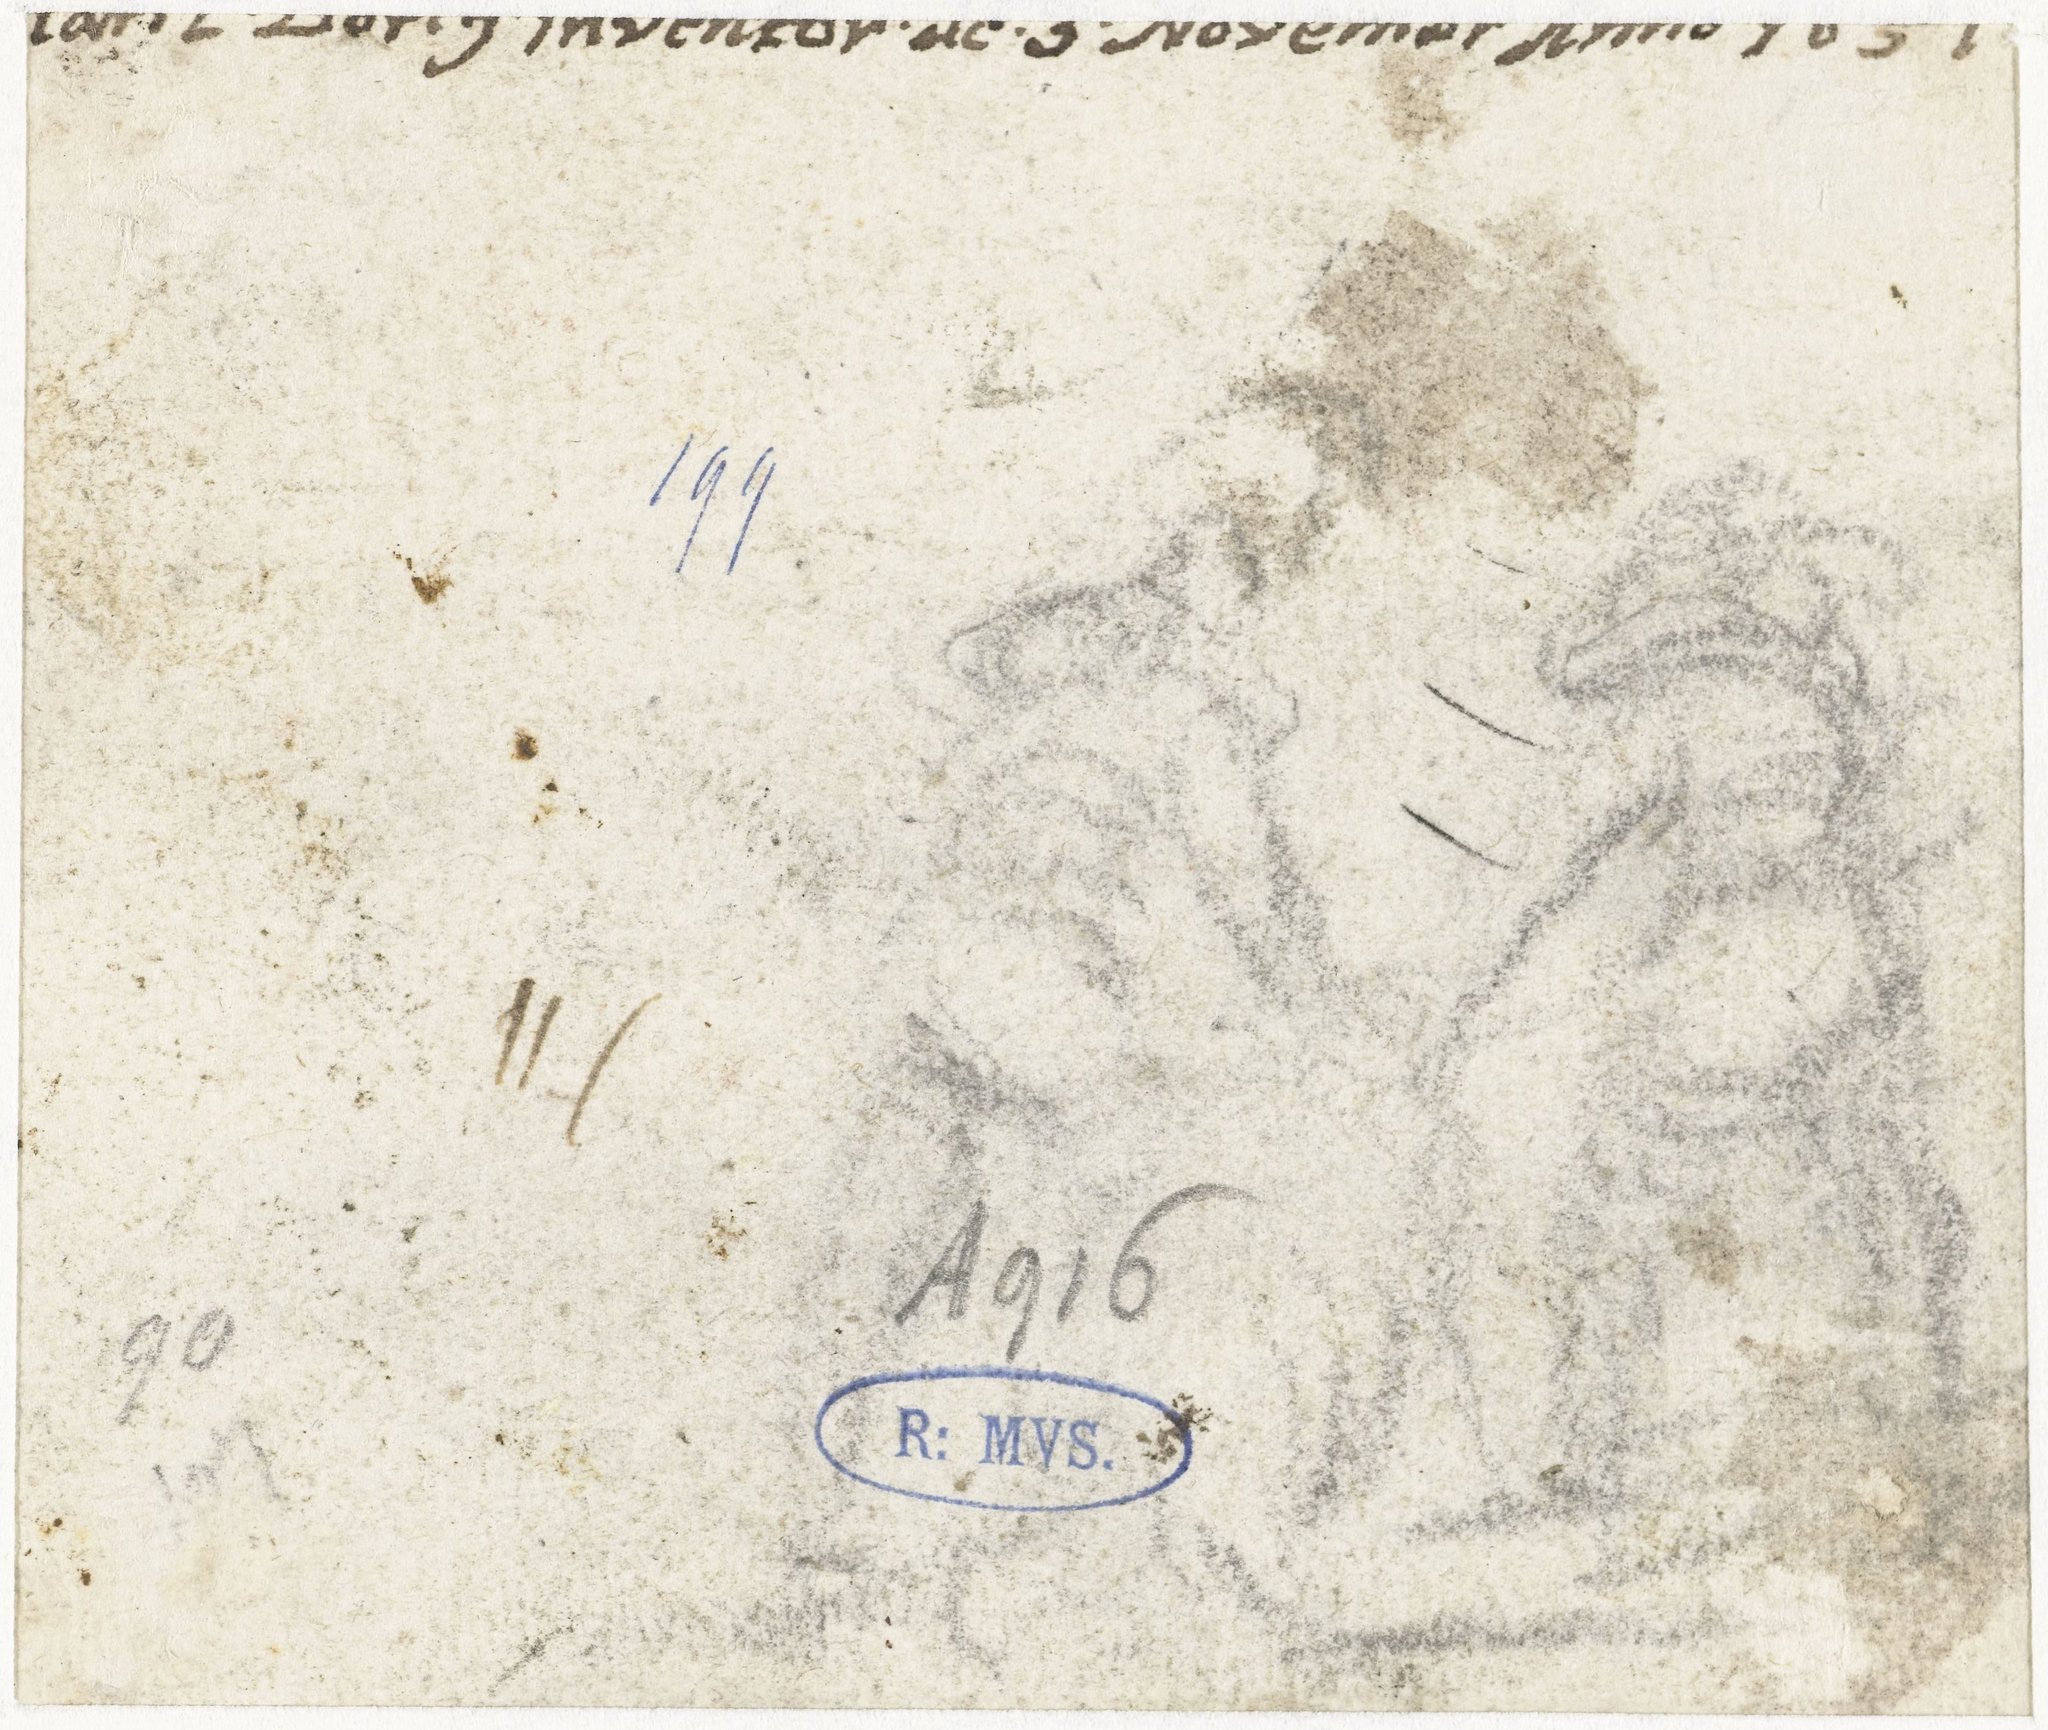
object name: drawing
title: Twee jongens trekken een schaap voort, van achteren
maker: harmen ter borch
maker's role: draughtsman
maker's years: 1638-1677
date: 1651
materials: chalk, paper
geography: zwolle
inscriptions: annotation: ‘Har[man] t.Borch. inventor. de[n] 5 Novembr Anno 1651’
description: Afbeelding overgetrokken van de voorzijde, waarschijnlijk door licht door het papier te laten schijnen en de lijnen over te trekken met krijt of een vroege vorm van carbonpapier.